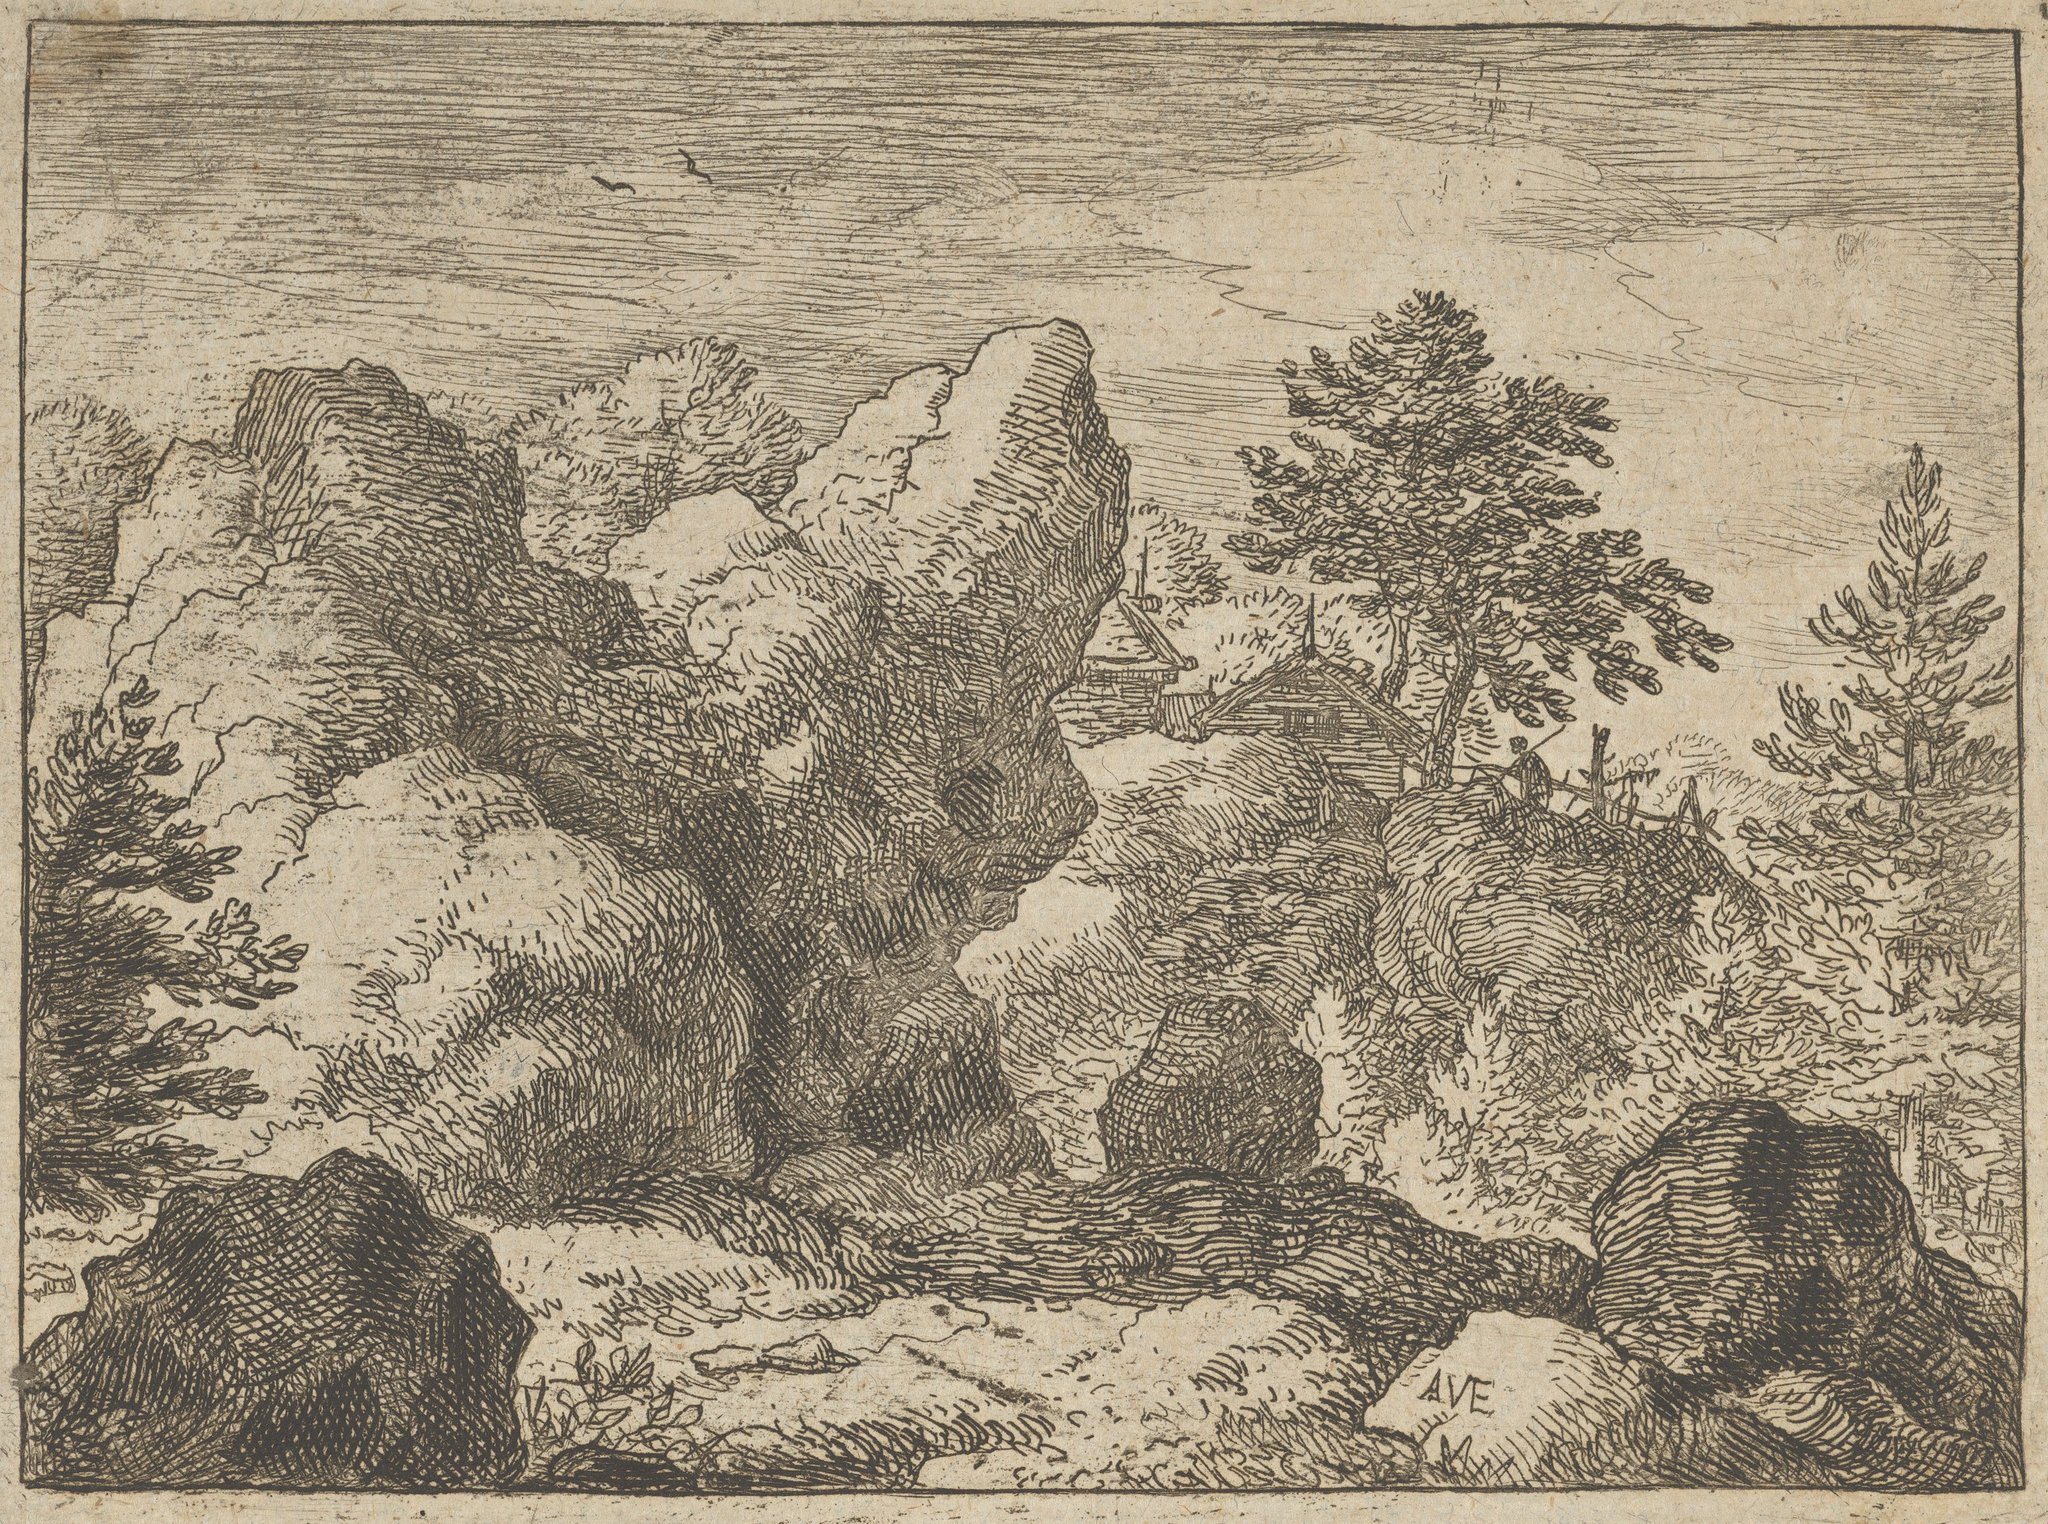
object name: print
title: The Pointed Rock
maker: allart van everdingen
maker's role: artist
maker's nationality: dutch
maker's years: 1621-1675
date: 1601-1700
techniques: engraving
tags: landscapes,trees